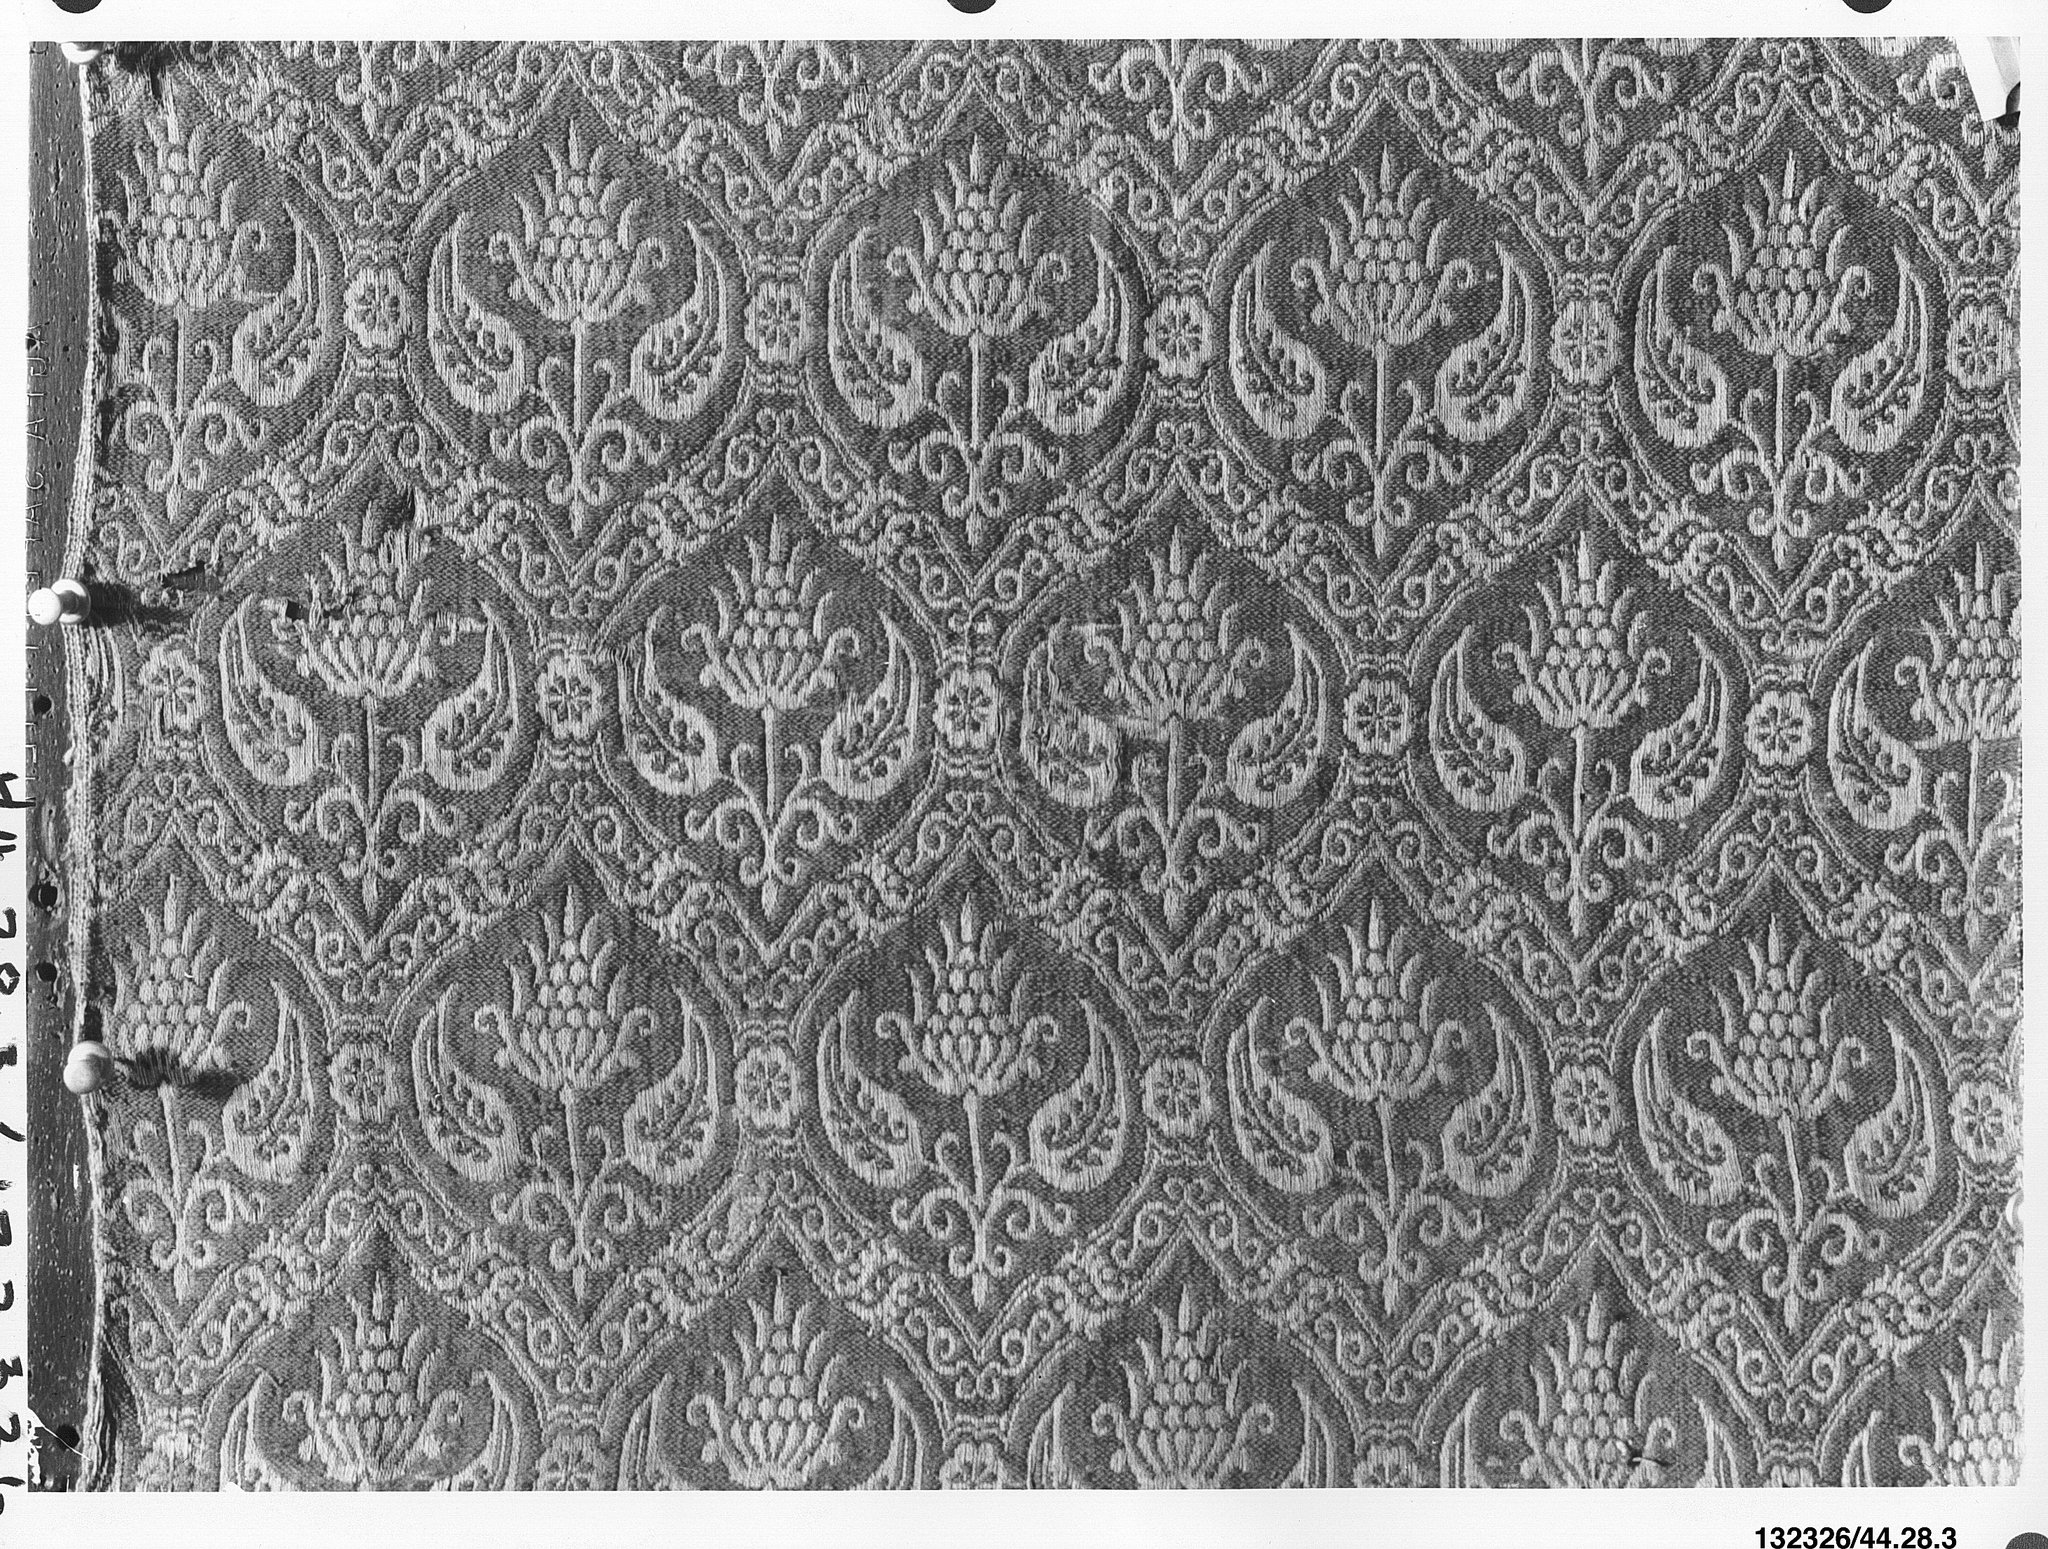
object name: piece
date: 1501-1600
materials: hemp, wool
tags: leaves